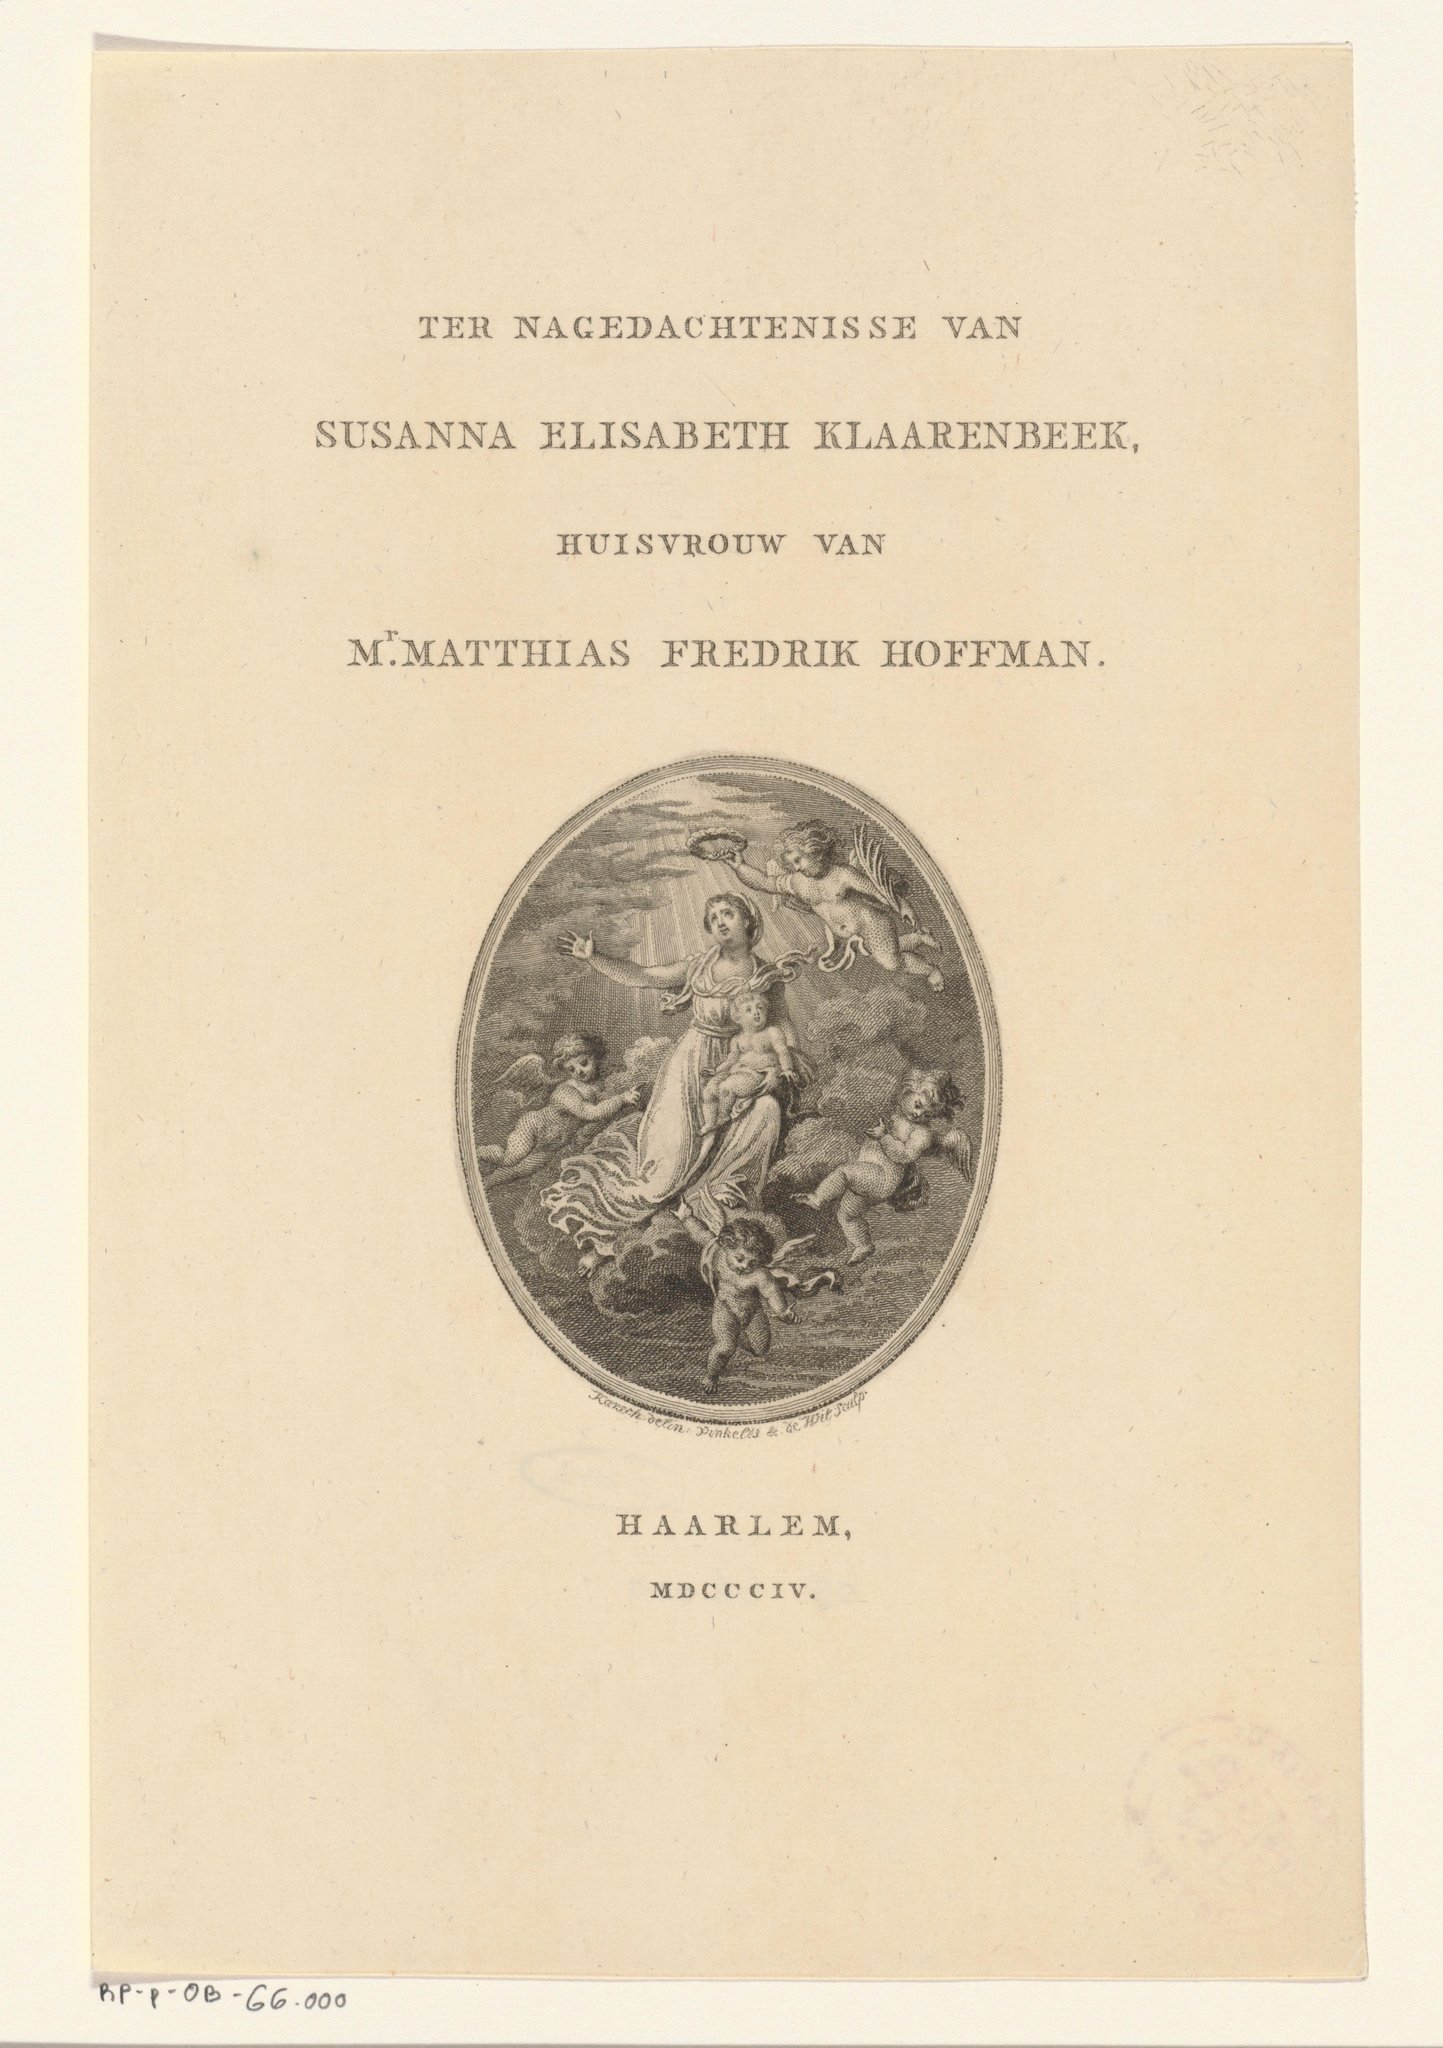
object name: titelblad, titelpagina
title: Titelpagina voor: P. H. Klaarenbeek 'Ter nagedachtenisse van Susanna Elisabeth Klaarenbeek', 1804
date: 1804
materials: paper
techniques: engraving, etching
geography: amsterdam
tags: angels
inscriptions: collector's mark: Lugt 240, collector's mark: Lugt 2228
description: Titelpagina voor: Klaarenbeek, Pieter Hermanus. Ter nagedachtenisse van Susanna Elisabeth Klaarenbeek. Haarlem, 1804.